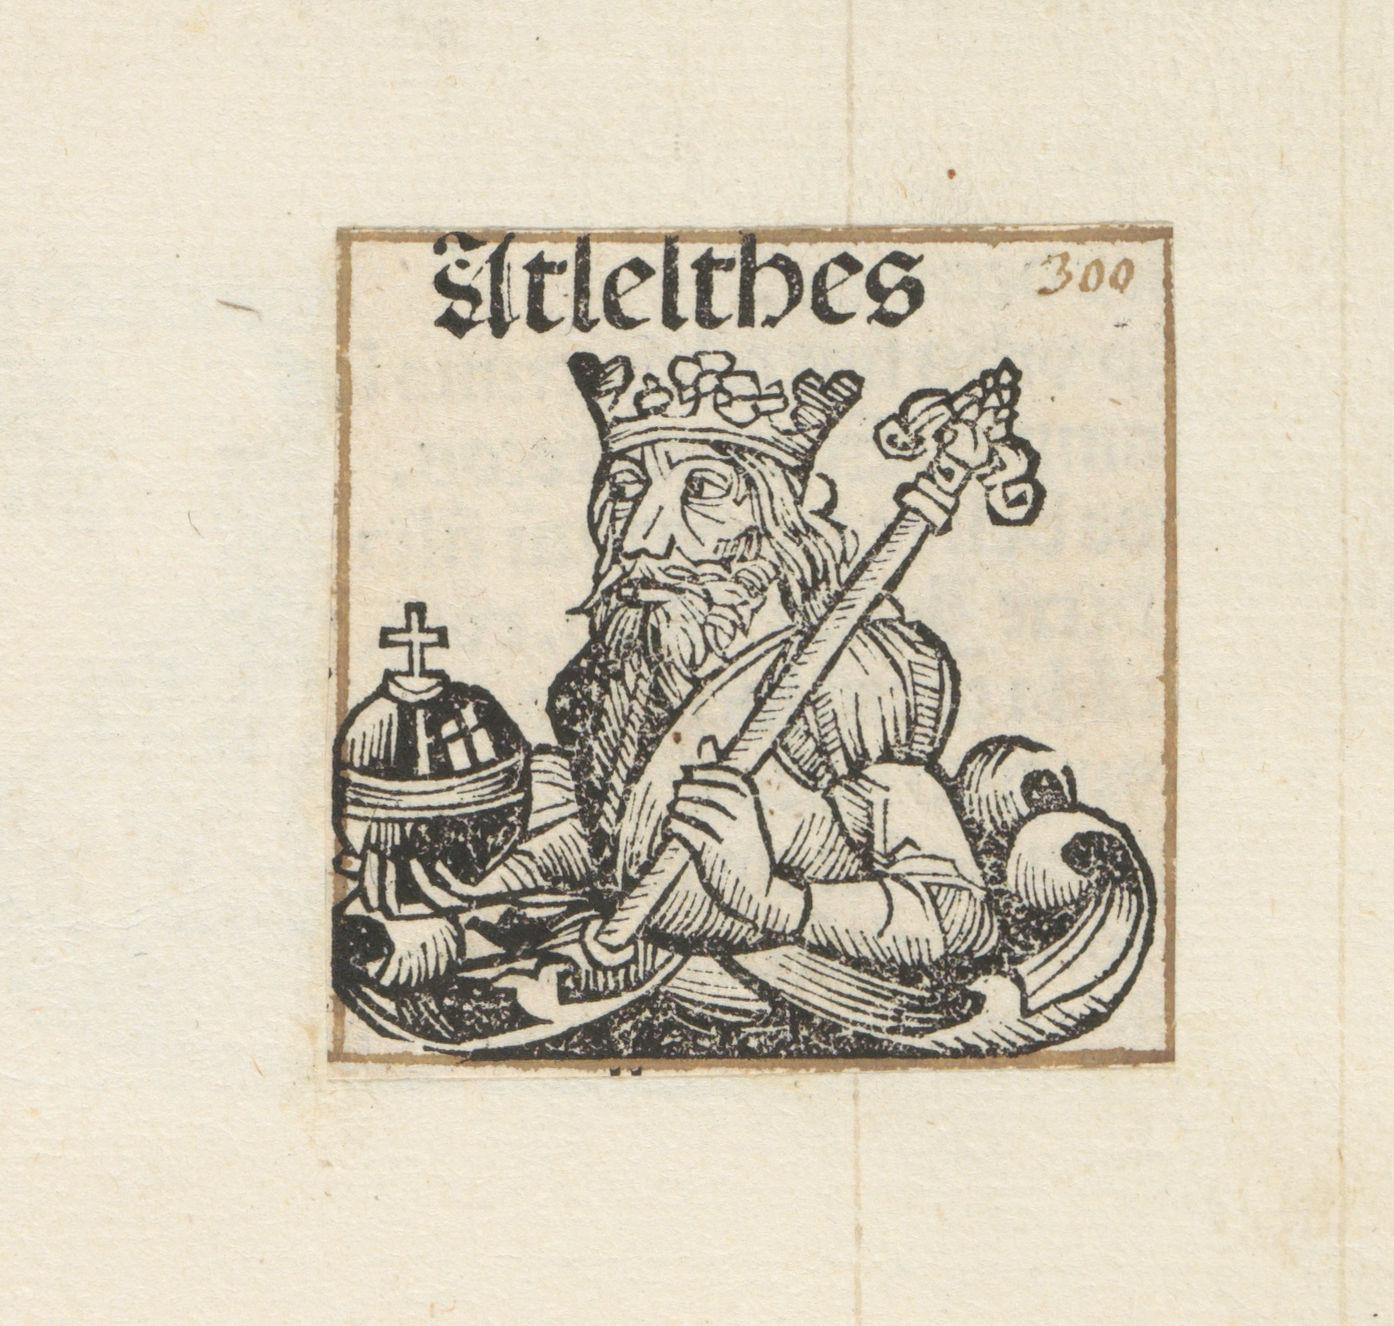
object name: print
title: Liber Chronicarum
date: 1493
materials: paper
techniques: letterpress printing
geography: nuremberg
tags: male persons from classical history, king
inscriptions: inscription: ‘300’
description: De houtsnede wordt gebruikt als boekillustratie in de Liber Chronicarum (of Neurenbergkroniek) van Hartmann Schedel, verschenen in het Latijn en Duits in 1493. Zie de Latijnse uitgave, folio 40r.